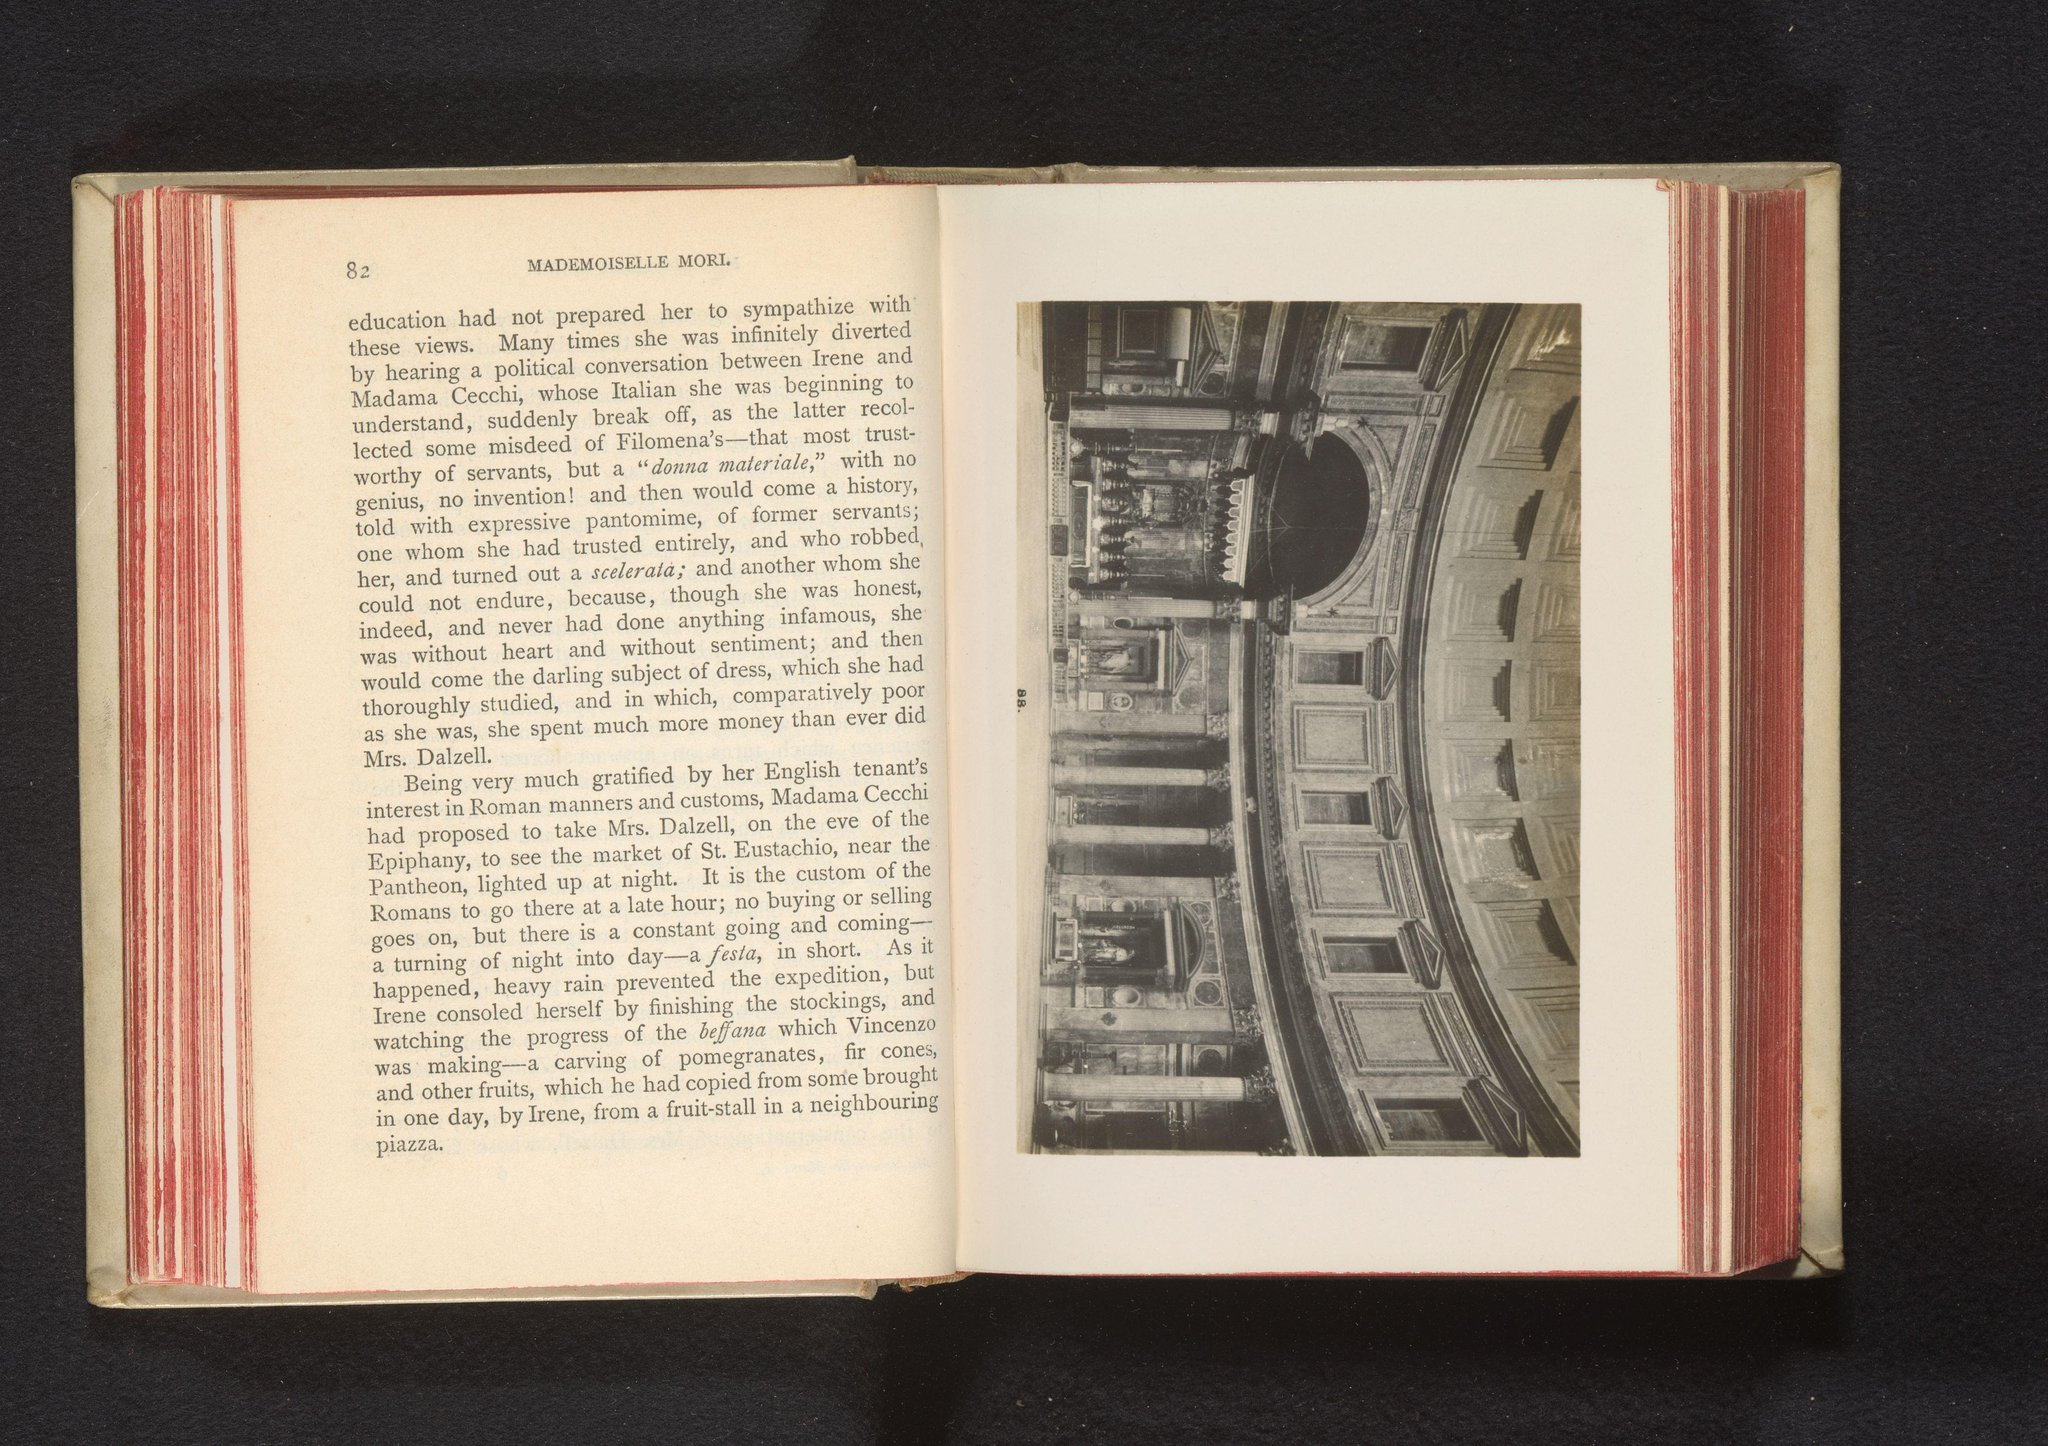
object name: photograph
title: Interieur van het Pantheon te Rome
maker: Anonymous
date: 1852-1862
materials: photographic support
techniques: gelatin silver print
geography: pantheon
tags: interior of church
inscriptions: number: ‘88.’